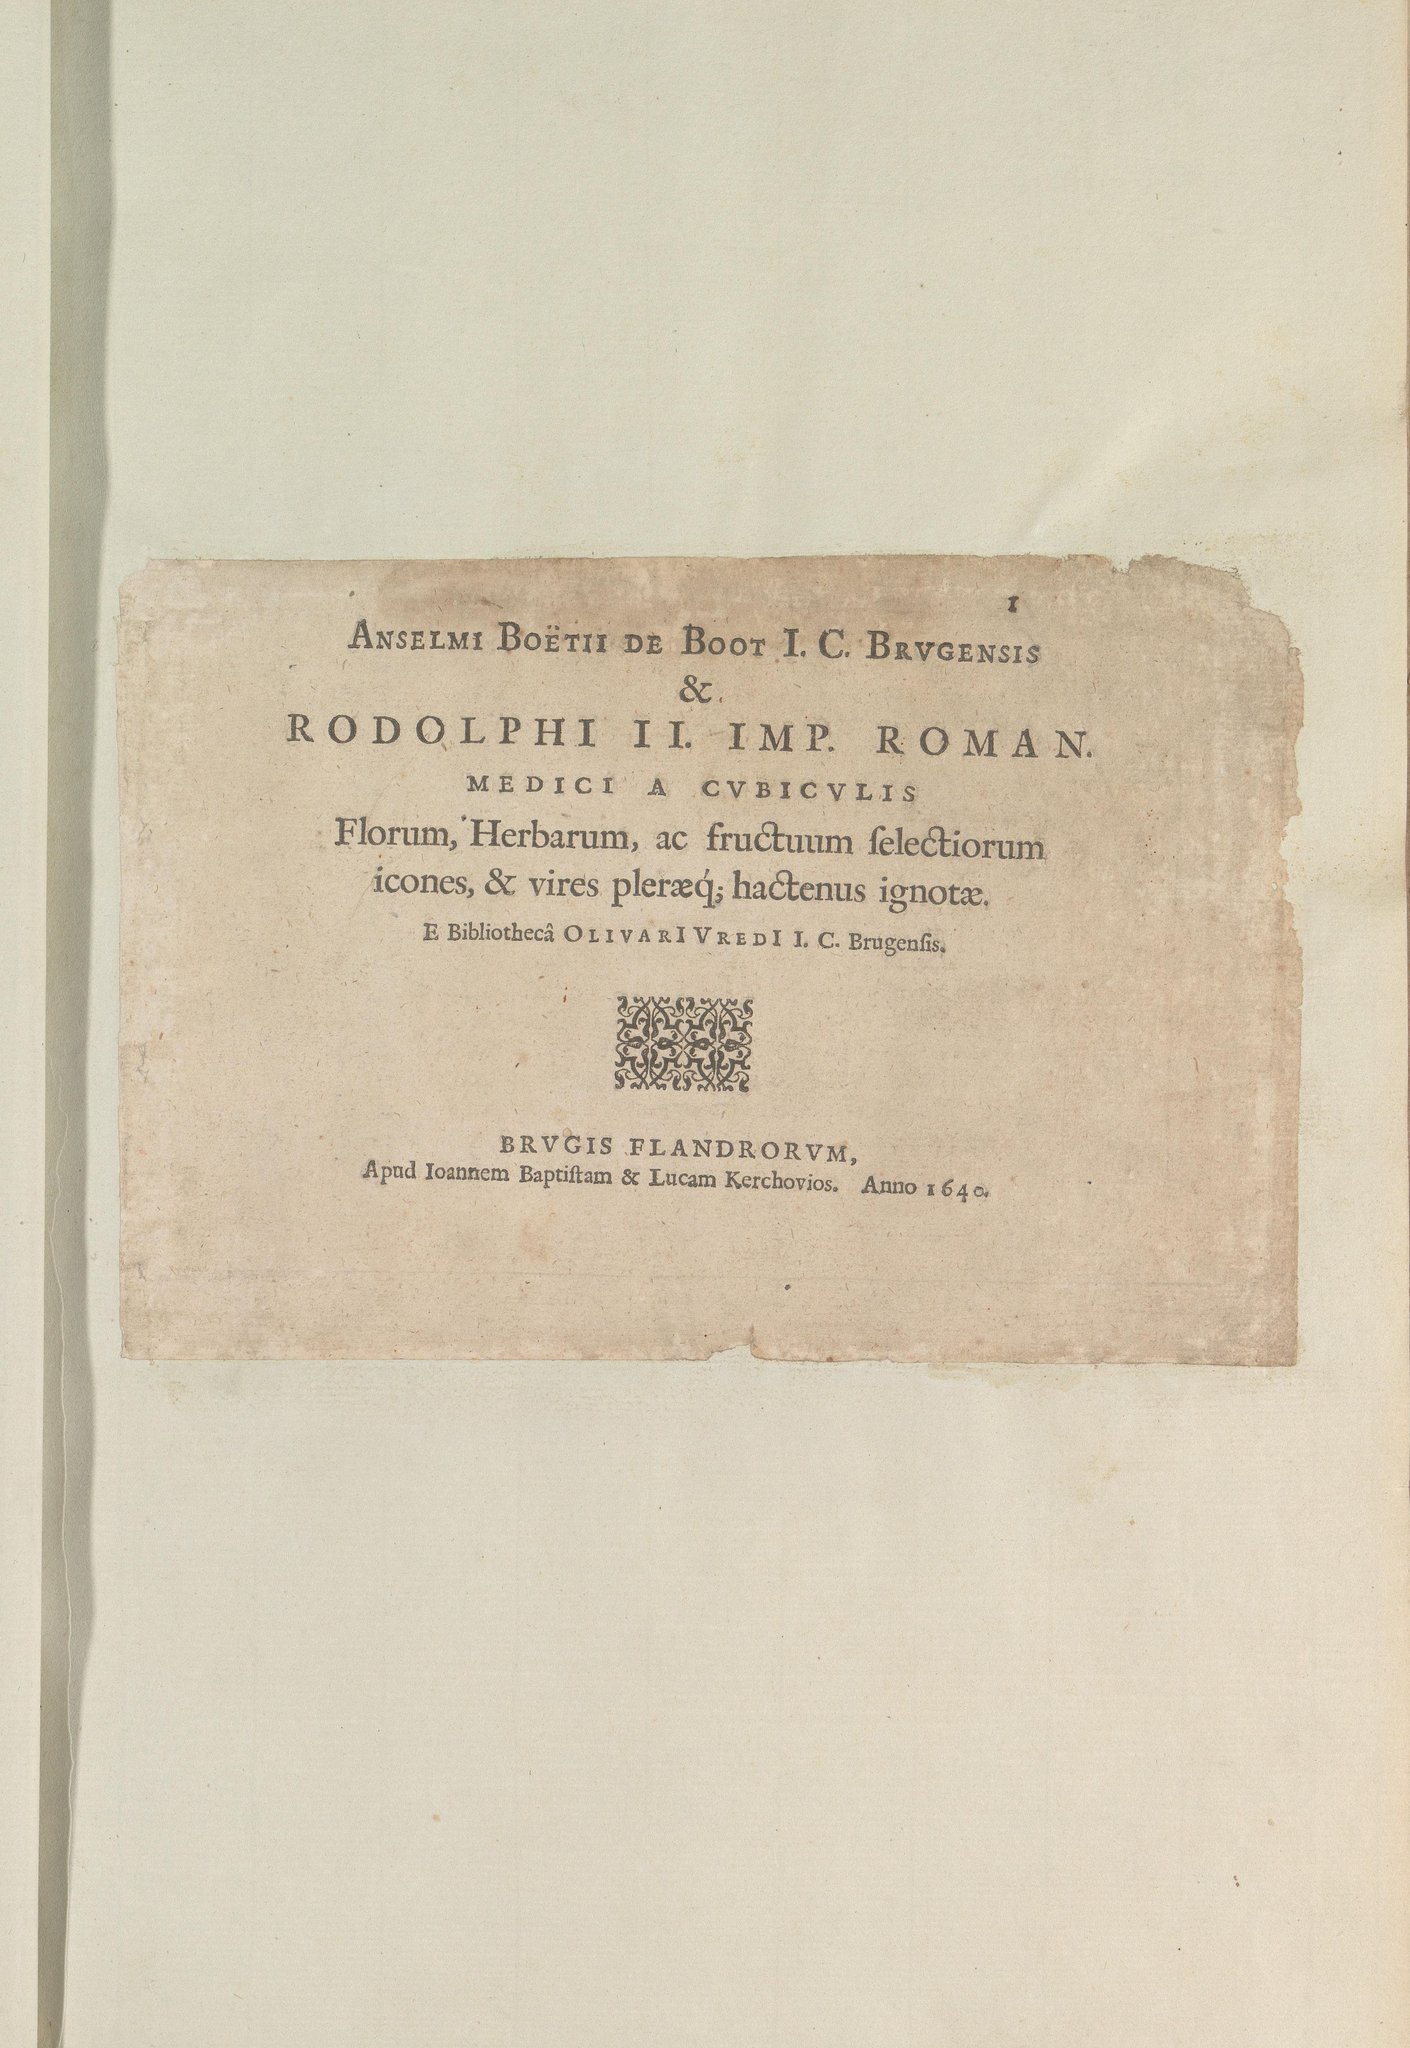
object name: titelblad, titelpagina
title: Titelpagina voor De Boodts herbarium van 1640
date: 1640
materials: ink, paper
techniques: letterpress printing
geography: bruges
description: Titelblad voor: Anselmi Boëtii de Boot I.C. Brugensis & Rodolphi II. Imp. Roman. medici a cubiculis Florum, Herbarum, ac fructuum selectiorum icones, & vires pleraeque hactenus ignotæ. Onderdeel van het album met bladen en platen uit De Boodts herbarium van 1640. Het twaalfde van twaalf albums met aquarellen van dieren, vogels en planten bekend rond 1600, gemaakt in opdracht van keizer Rudolf II.